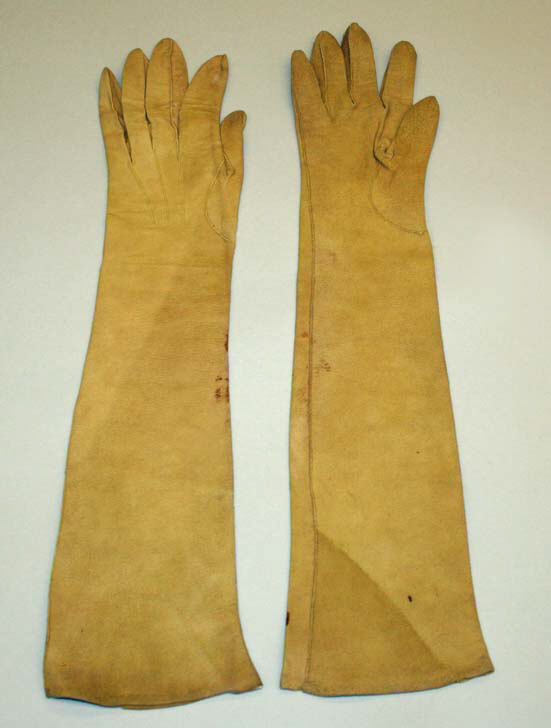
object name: glove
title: Gloves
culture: italian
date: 1767-1800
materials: leather